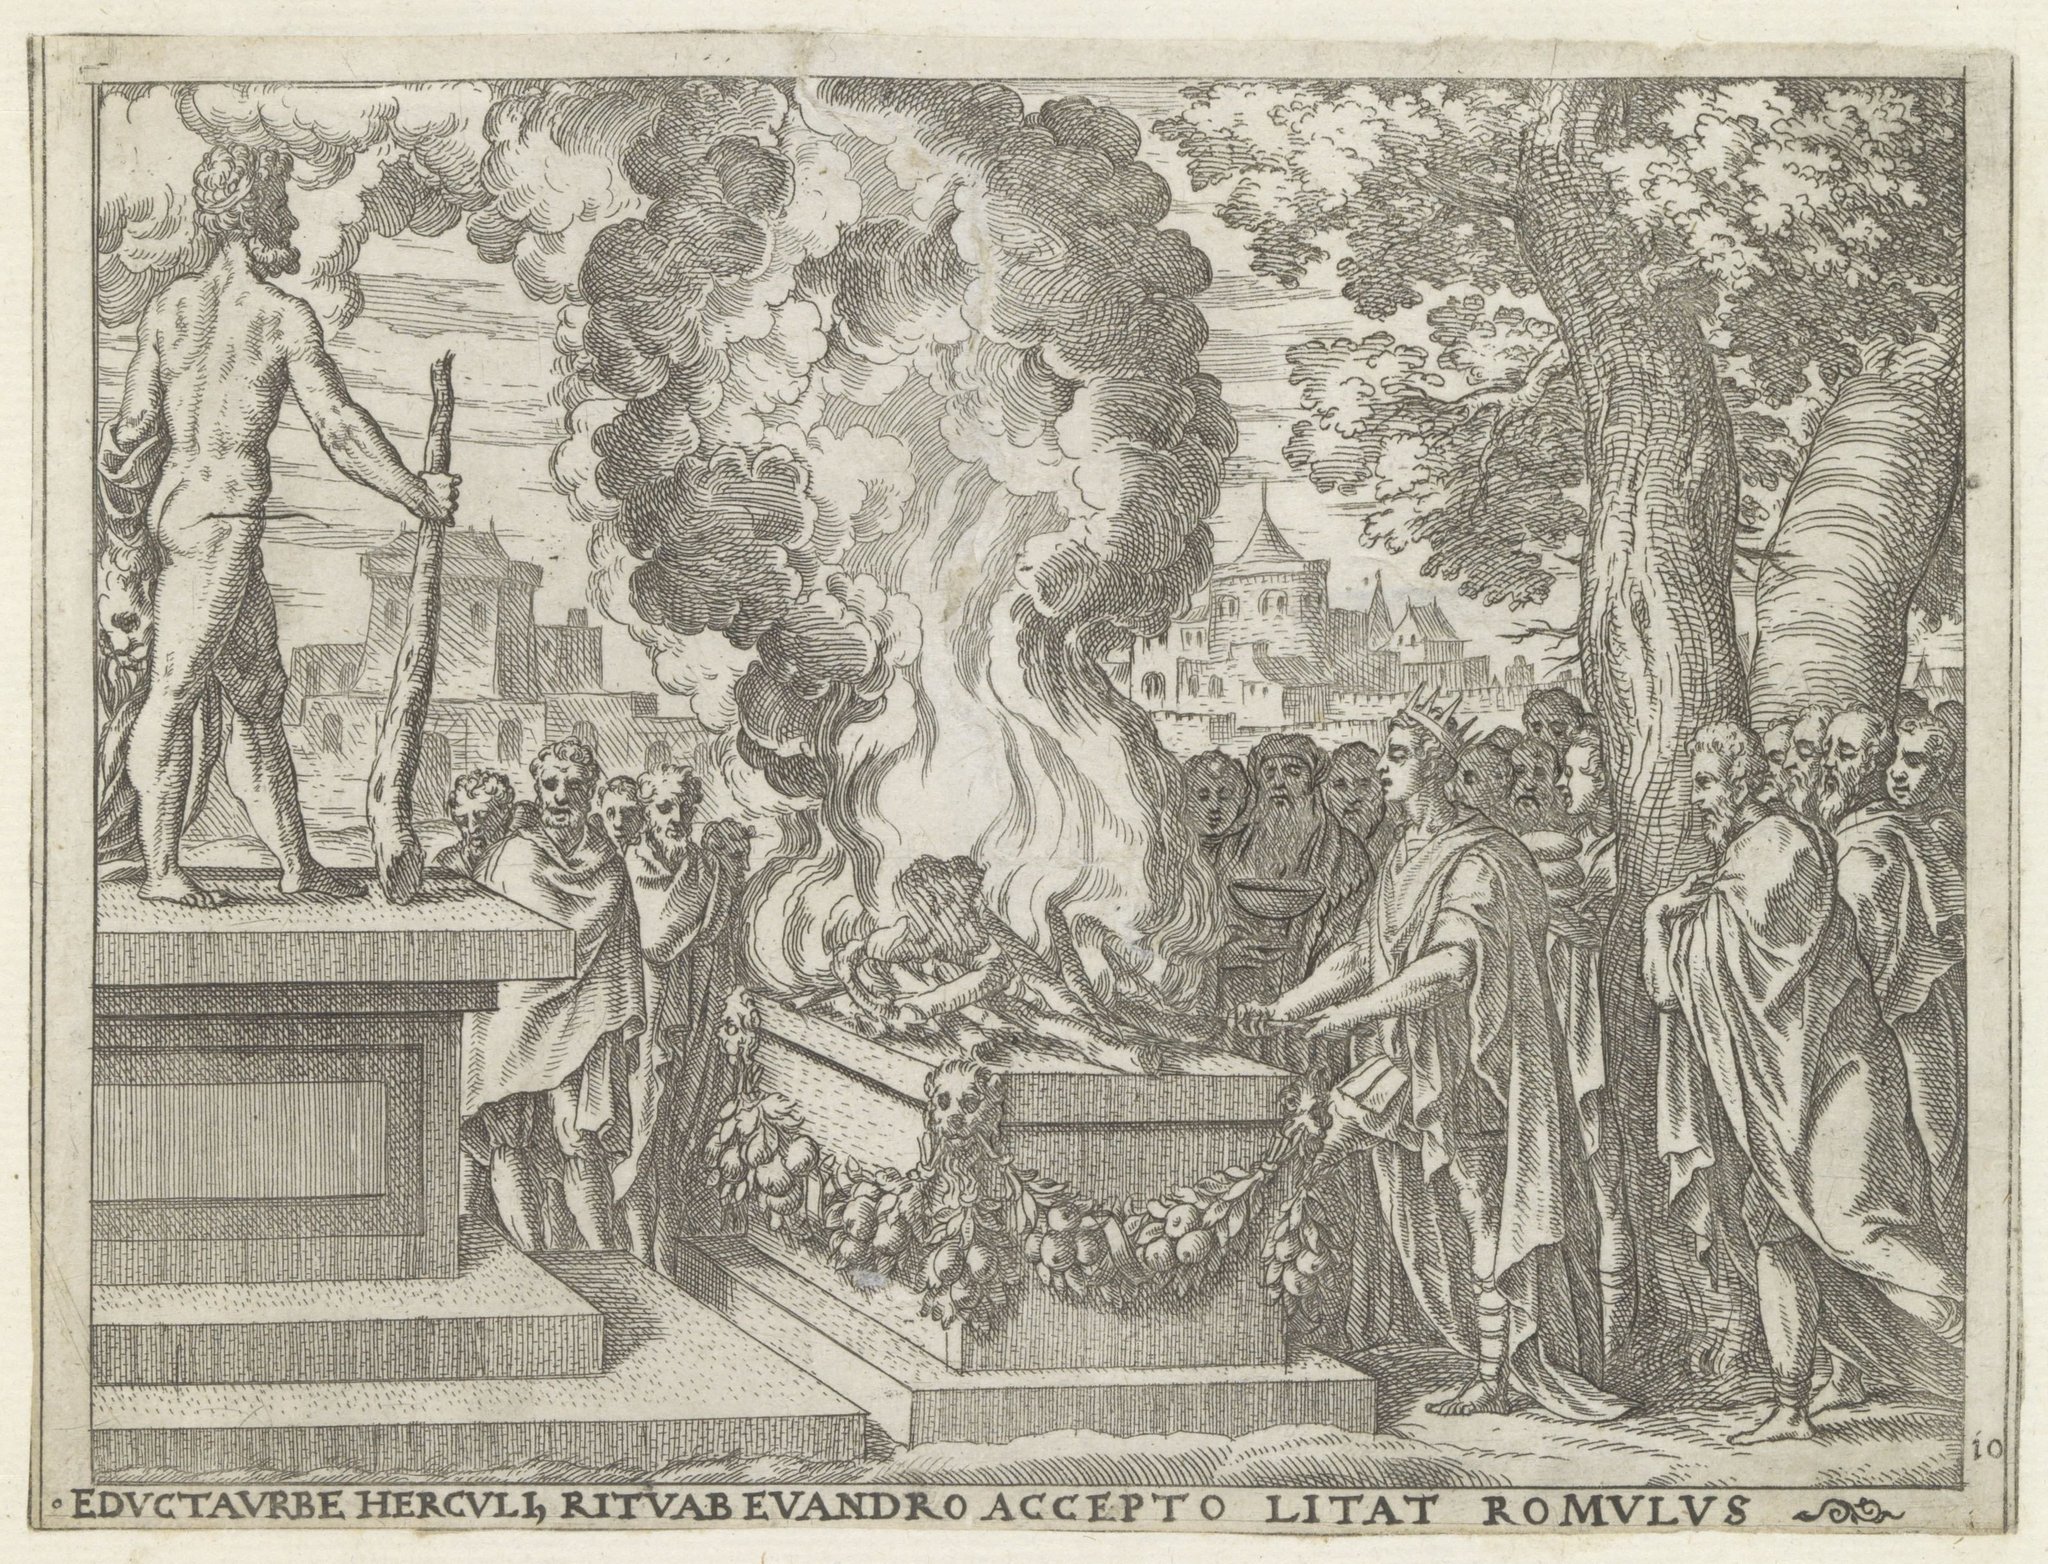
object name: album leaf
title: Romulus offert aan de god Hercules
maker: giovanni battista fontana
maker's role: draughtsman, painter, print maker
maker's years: 1524-1587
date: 1572-1573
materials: paper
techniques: etching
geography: italy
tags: romulus institutes the cult of hercules, (story of) romulus and remus, sacrifice ~ non-christian religions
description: Romulus en zijn volgelingen staan voor een altaar waarop een offer ligt te branden. Links een beeld van de god Hercules. De prent maakt deel uit van een album.